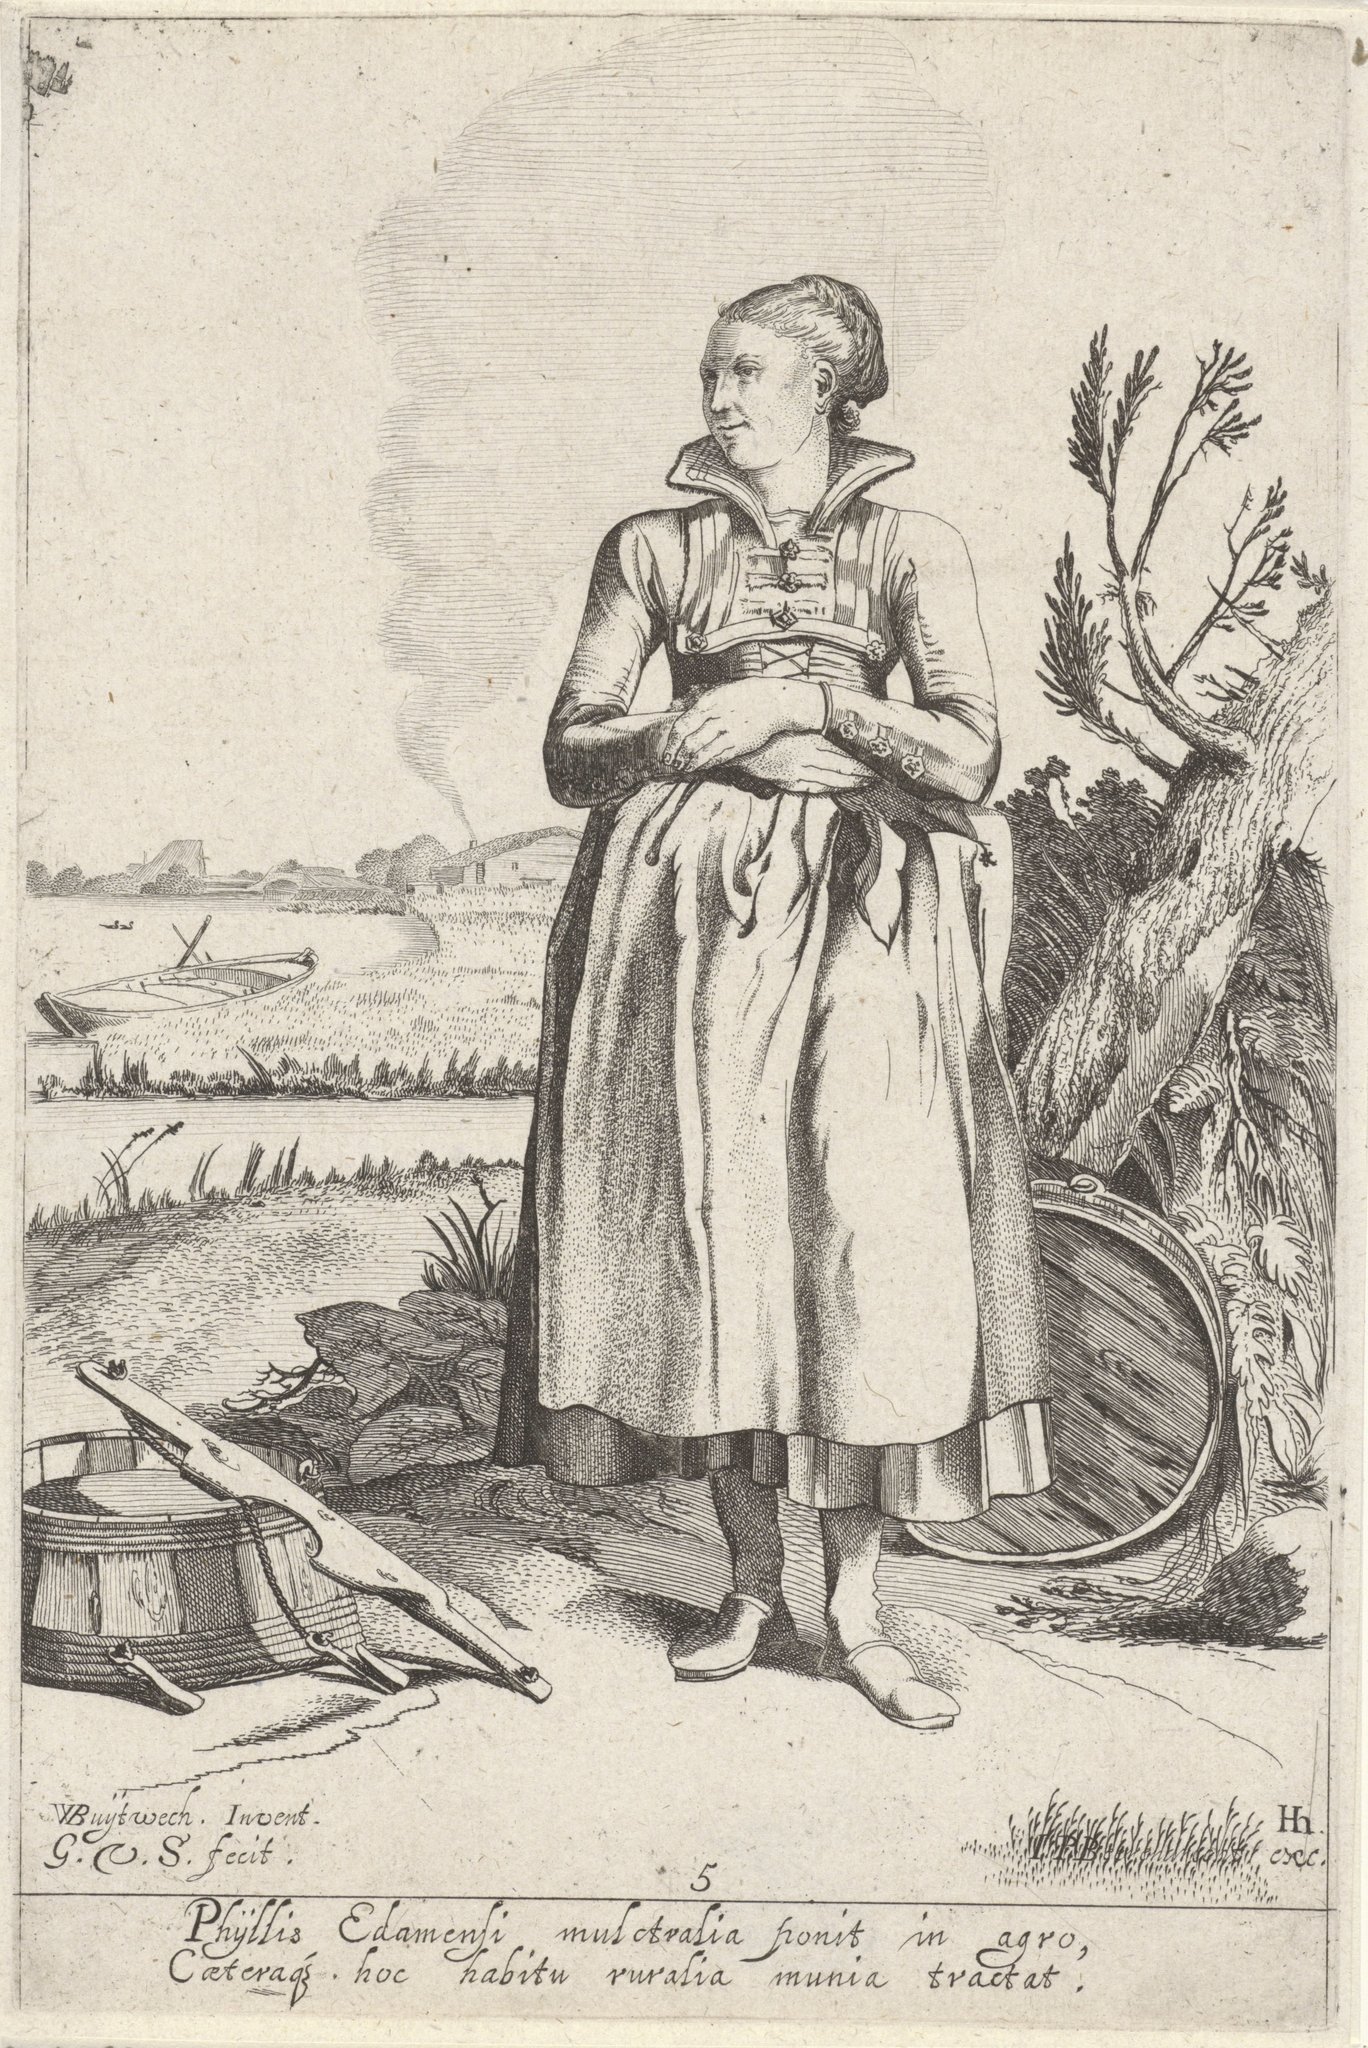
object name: print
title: Meisje uit Edam, van voren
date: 1620-1624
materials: paper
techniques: engraving, etching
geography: northern netherlands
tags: folk costume, regional costume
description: Staande jonge vrouw uit Edam, van voren gezien. Nr. 5 in een serie van acht jonge vrouwen in Noord-Hollandse klederdrachten. Met onderschrift van twee regels in het Latijn.